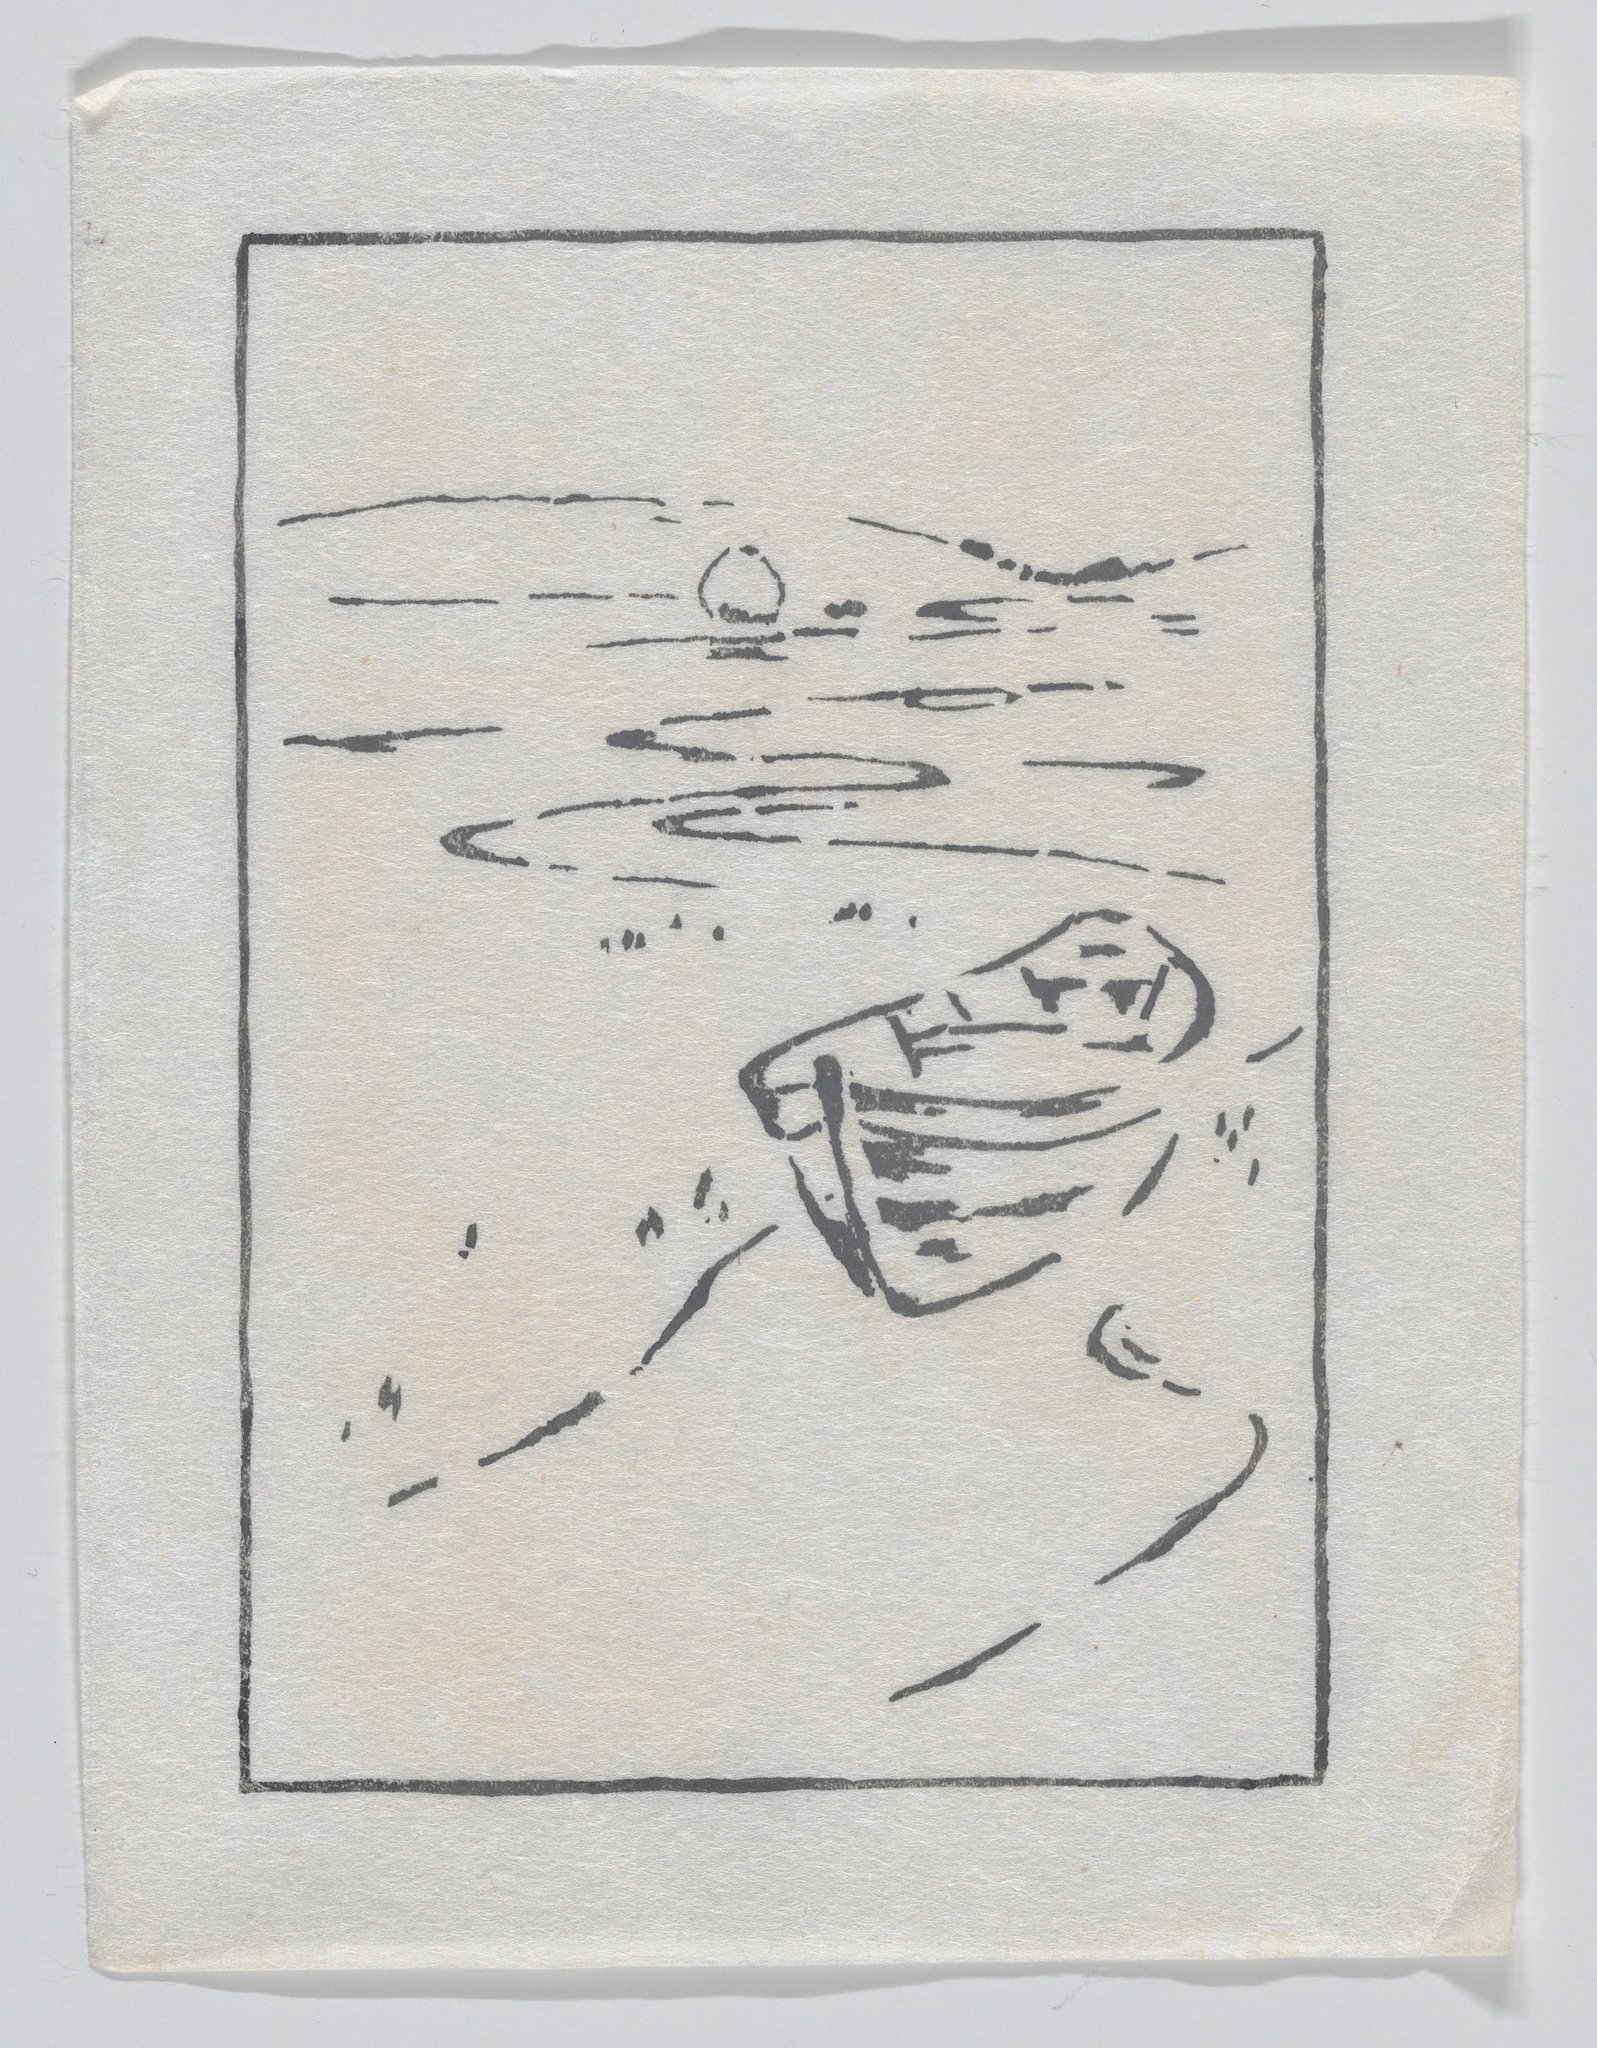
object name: proof print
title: "The Derelict" or "The Lost Boat"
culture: american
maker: arthur wesley dow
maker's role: artist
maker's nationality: american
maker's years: 1857-1922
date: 1916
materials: paper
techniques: woodcut, printing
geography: united states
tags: boats